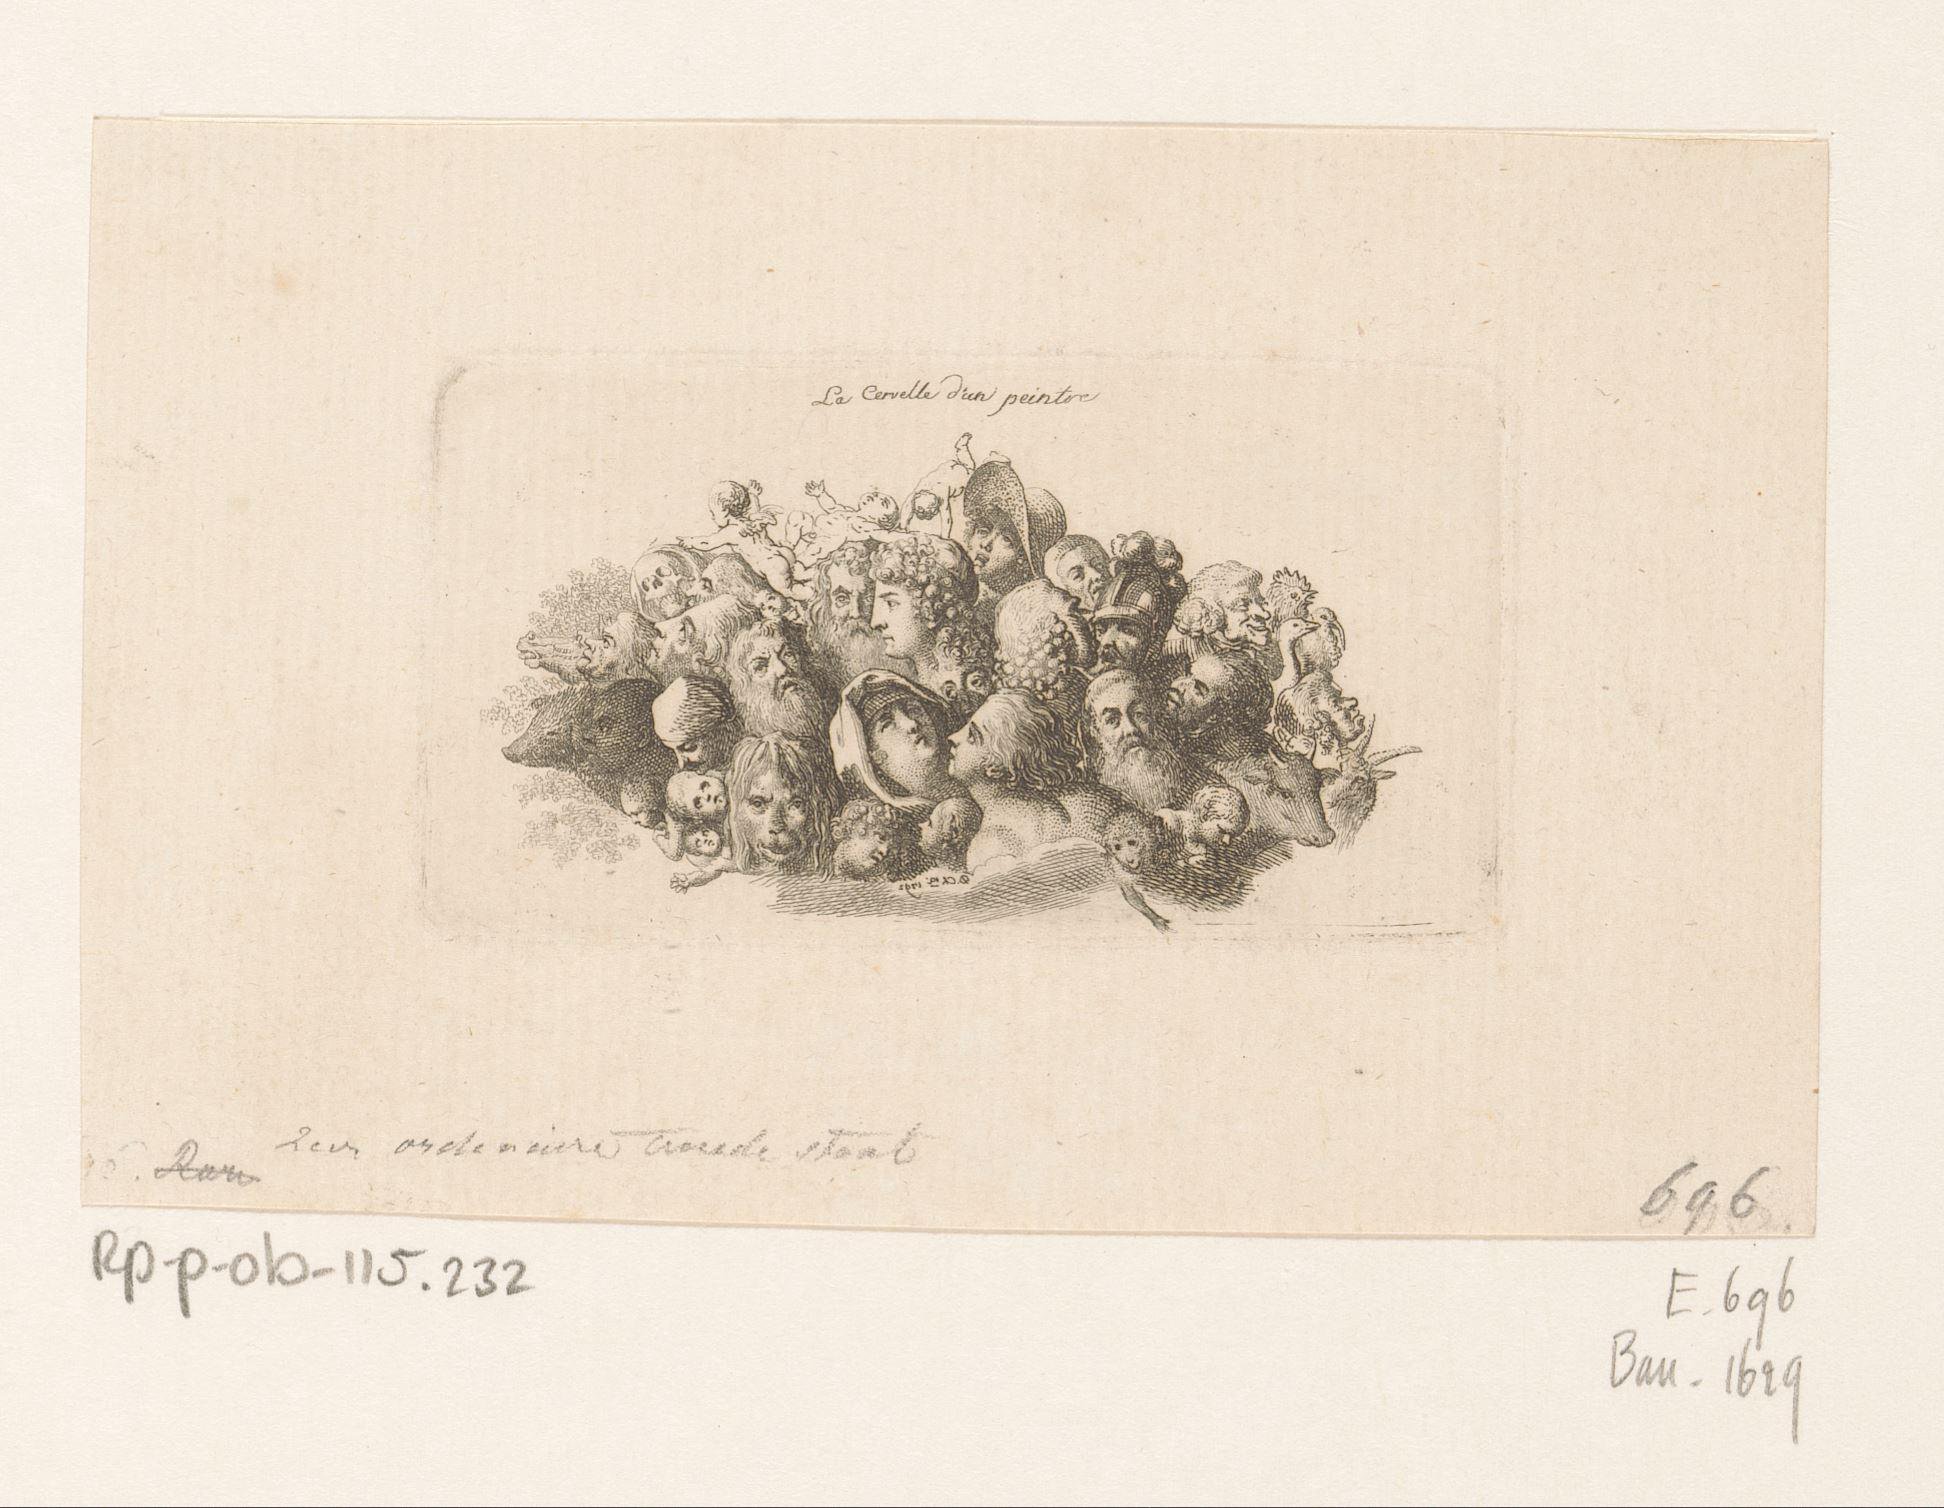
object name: print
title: La Cervelle d'un peintre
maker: daniel nikolaus chodowiecki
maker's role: draughtsman, print maker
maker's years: 1726-1801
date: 1792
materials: paper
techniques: etching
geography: berlin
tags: head (human), boar (male pig), monkeys, apes, death as skeleton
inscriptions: collector's mark: Lugt 2228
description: Koppen van verschillende menselijke karakters en dieren.